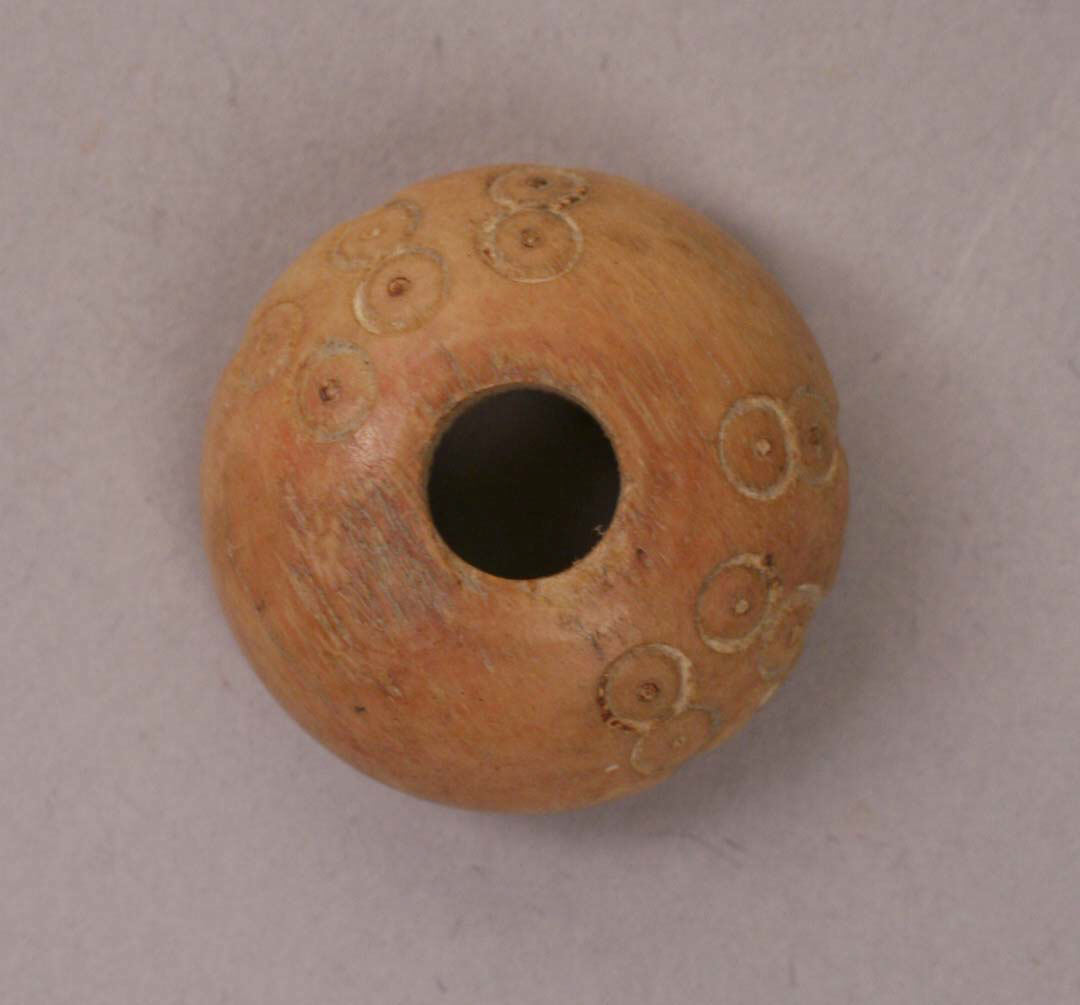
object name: button or bead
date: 801-1000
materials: bone, paint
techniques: incising, inlay, tinting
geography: iran